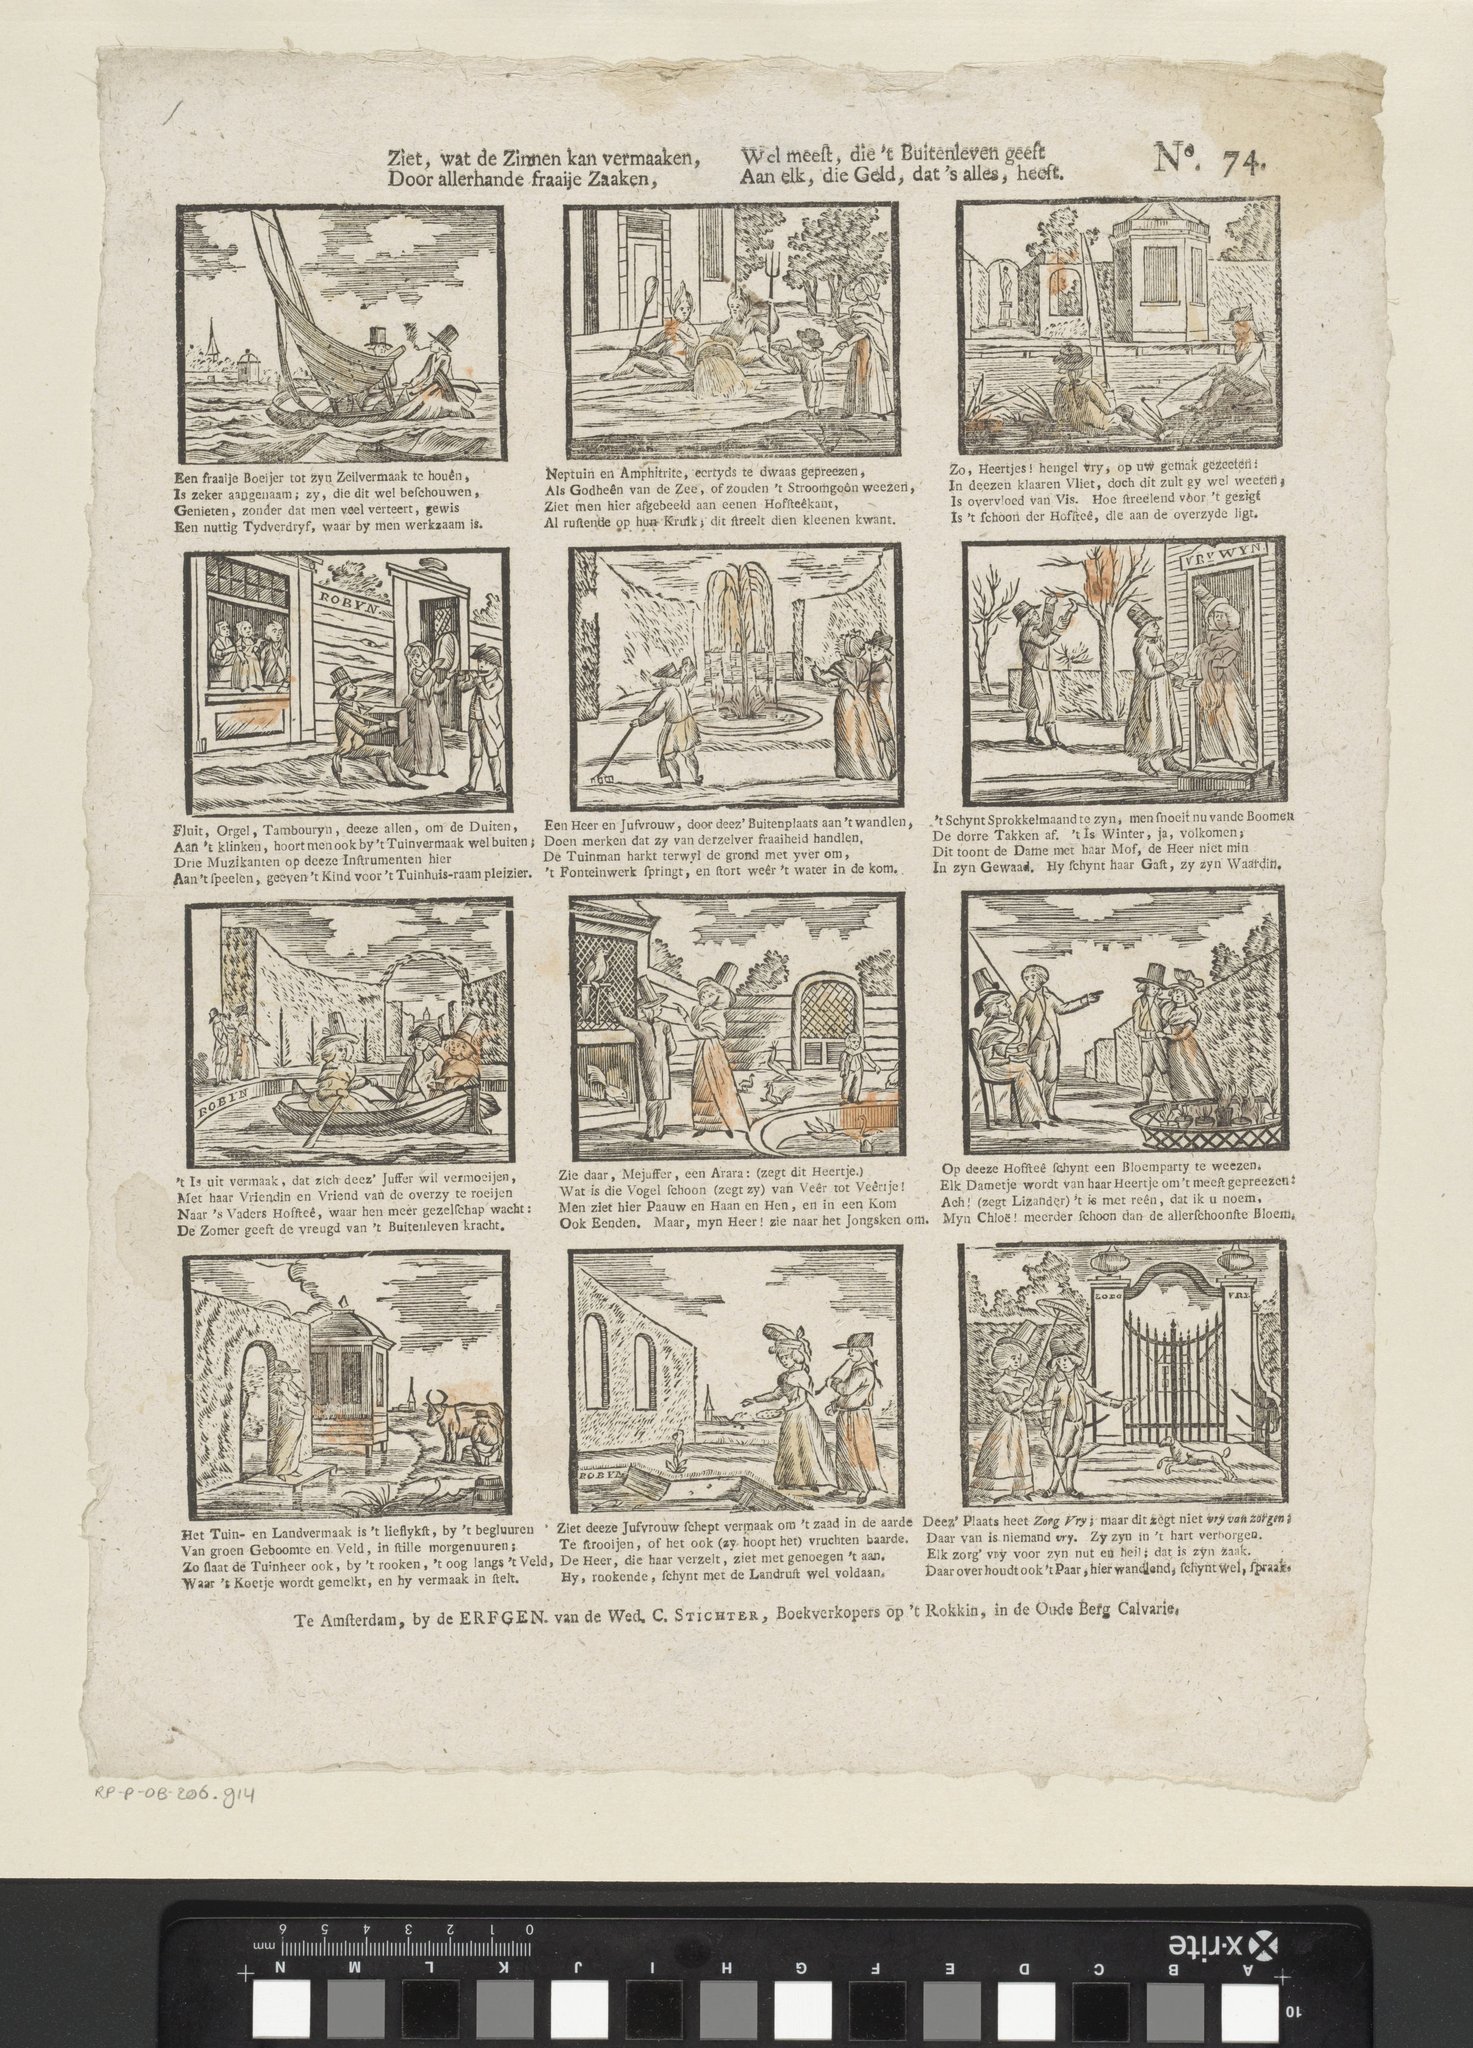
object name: print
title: Ziet, wat de zinnen kan vermaaken, / Door allerhande fraaije zaaken, / Wel meest, die 't buitenleven geeft / Aan elk, die geld, dat 's alles, heeft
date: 1715-1813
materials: paper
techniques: colour, letterpress printing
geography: amsterdam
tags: human types, garden fountain, fishing (sports), couple of lovers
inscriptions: collector's mark: Lugt 2760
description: Blad met 12 voorstellingen van verschillende figuren en bezigheden. Onder elke afbeelding een vierregelig vers. Genummerd rechtsboven: No. 74